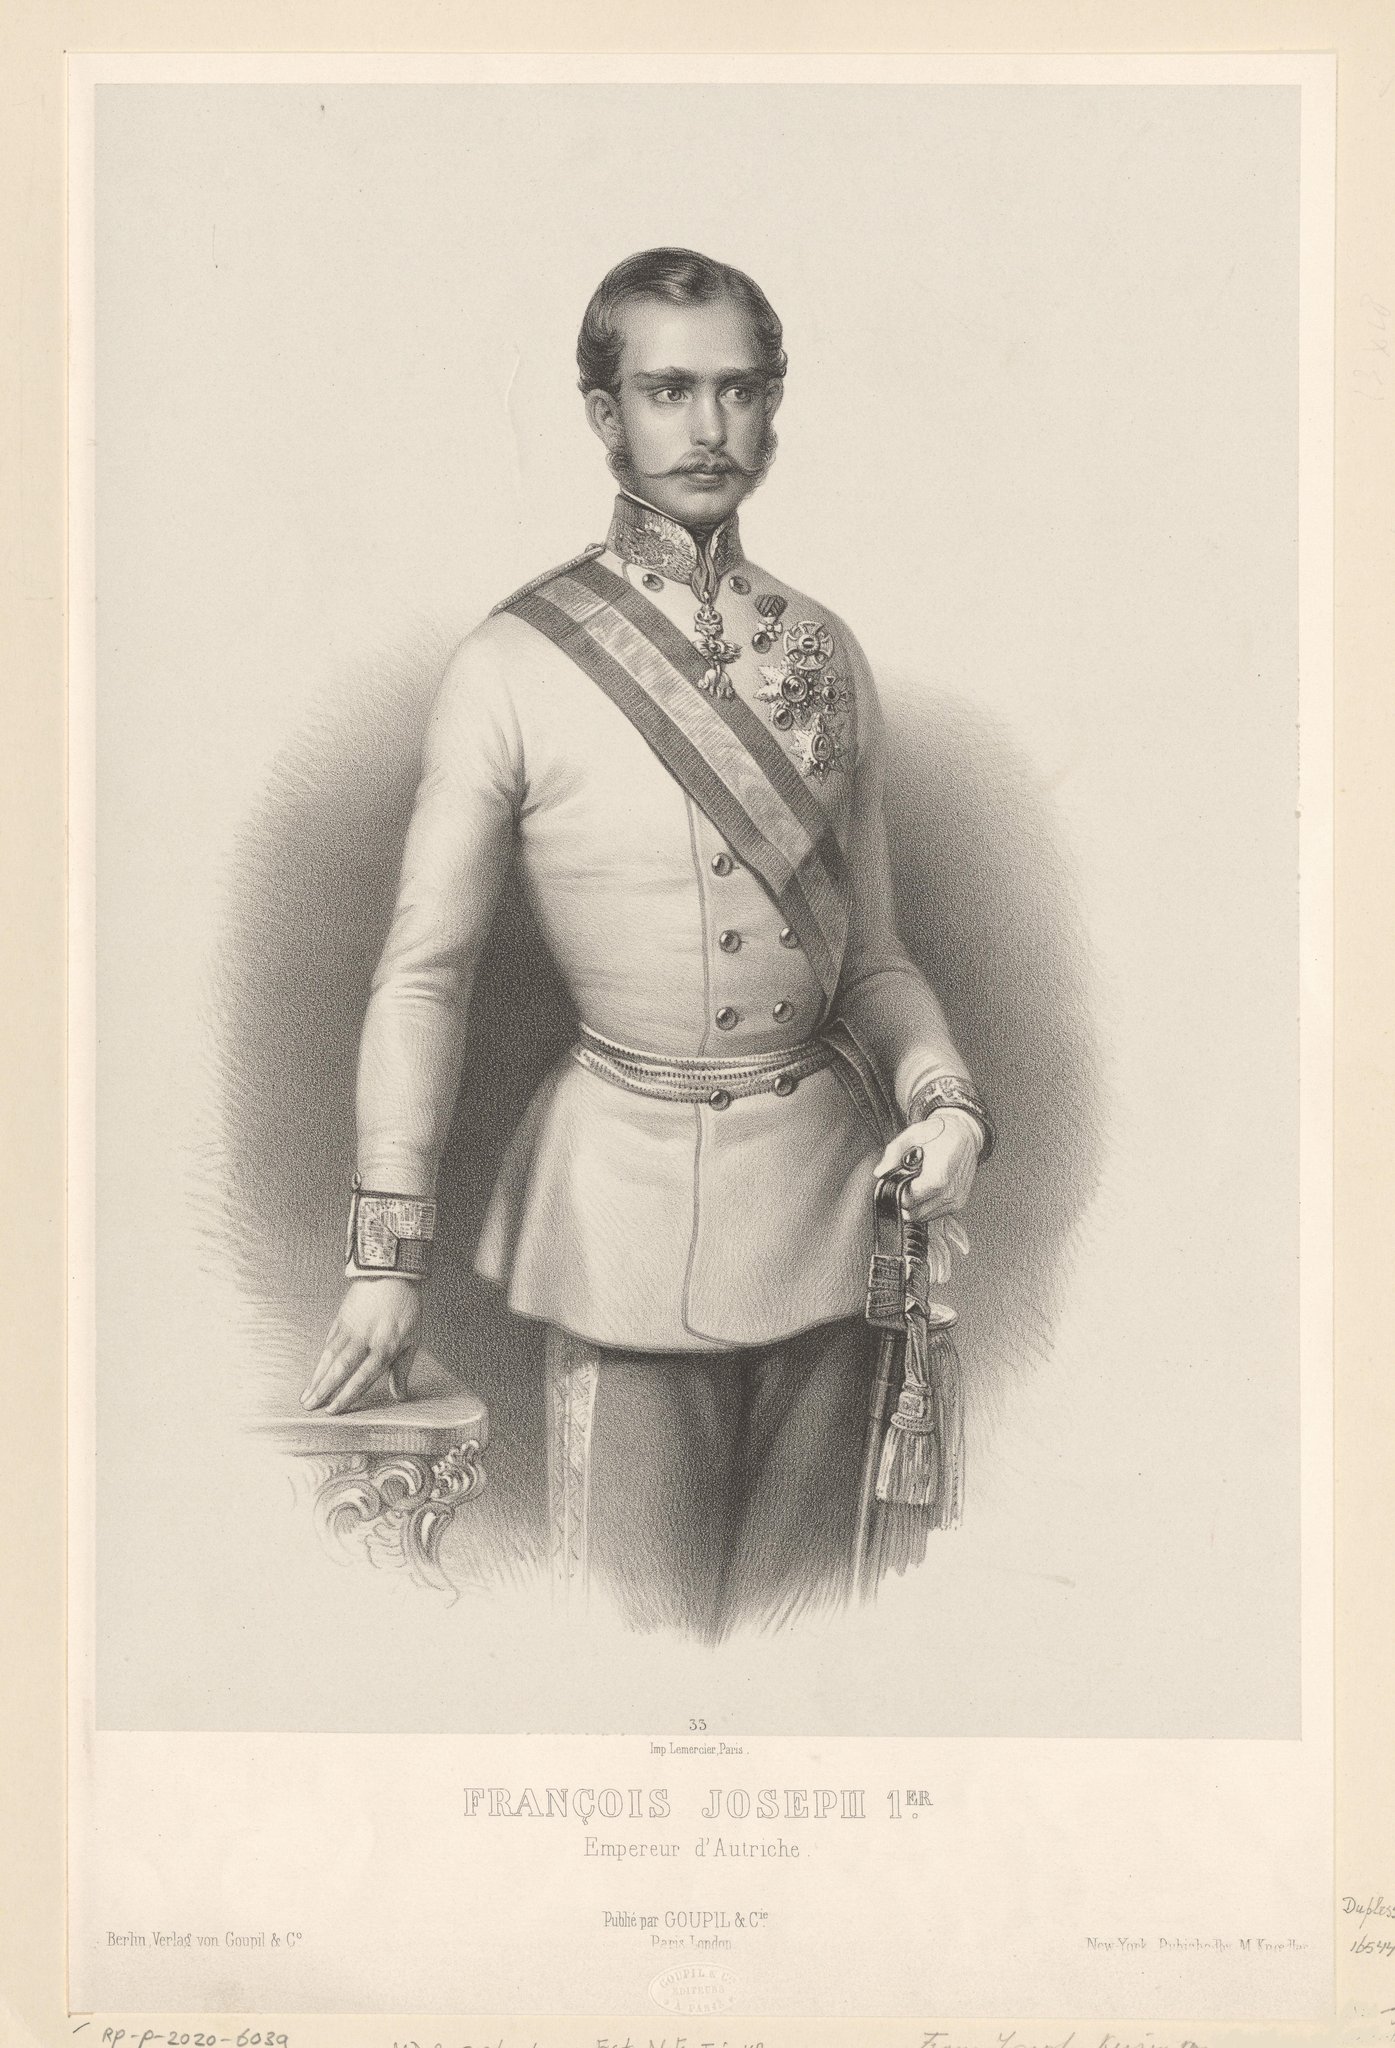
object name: print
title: Portret van Frans Jozef I van Oostenrijk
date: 1857-1878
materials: paper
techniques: lithograph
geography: paris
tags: historical persons, emperor, knighthood order of the golden fleece - insignia of a knighthood order, e.g.: badge, chain (with name of order)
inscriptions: check stamp: Lugt 1090